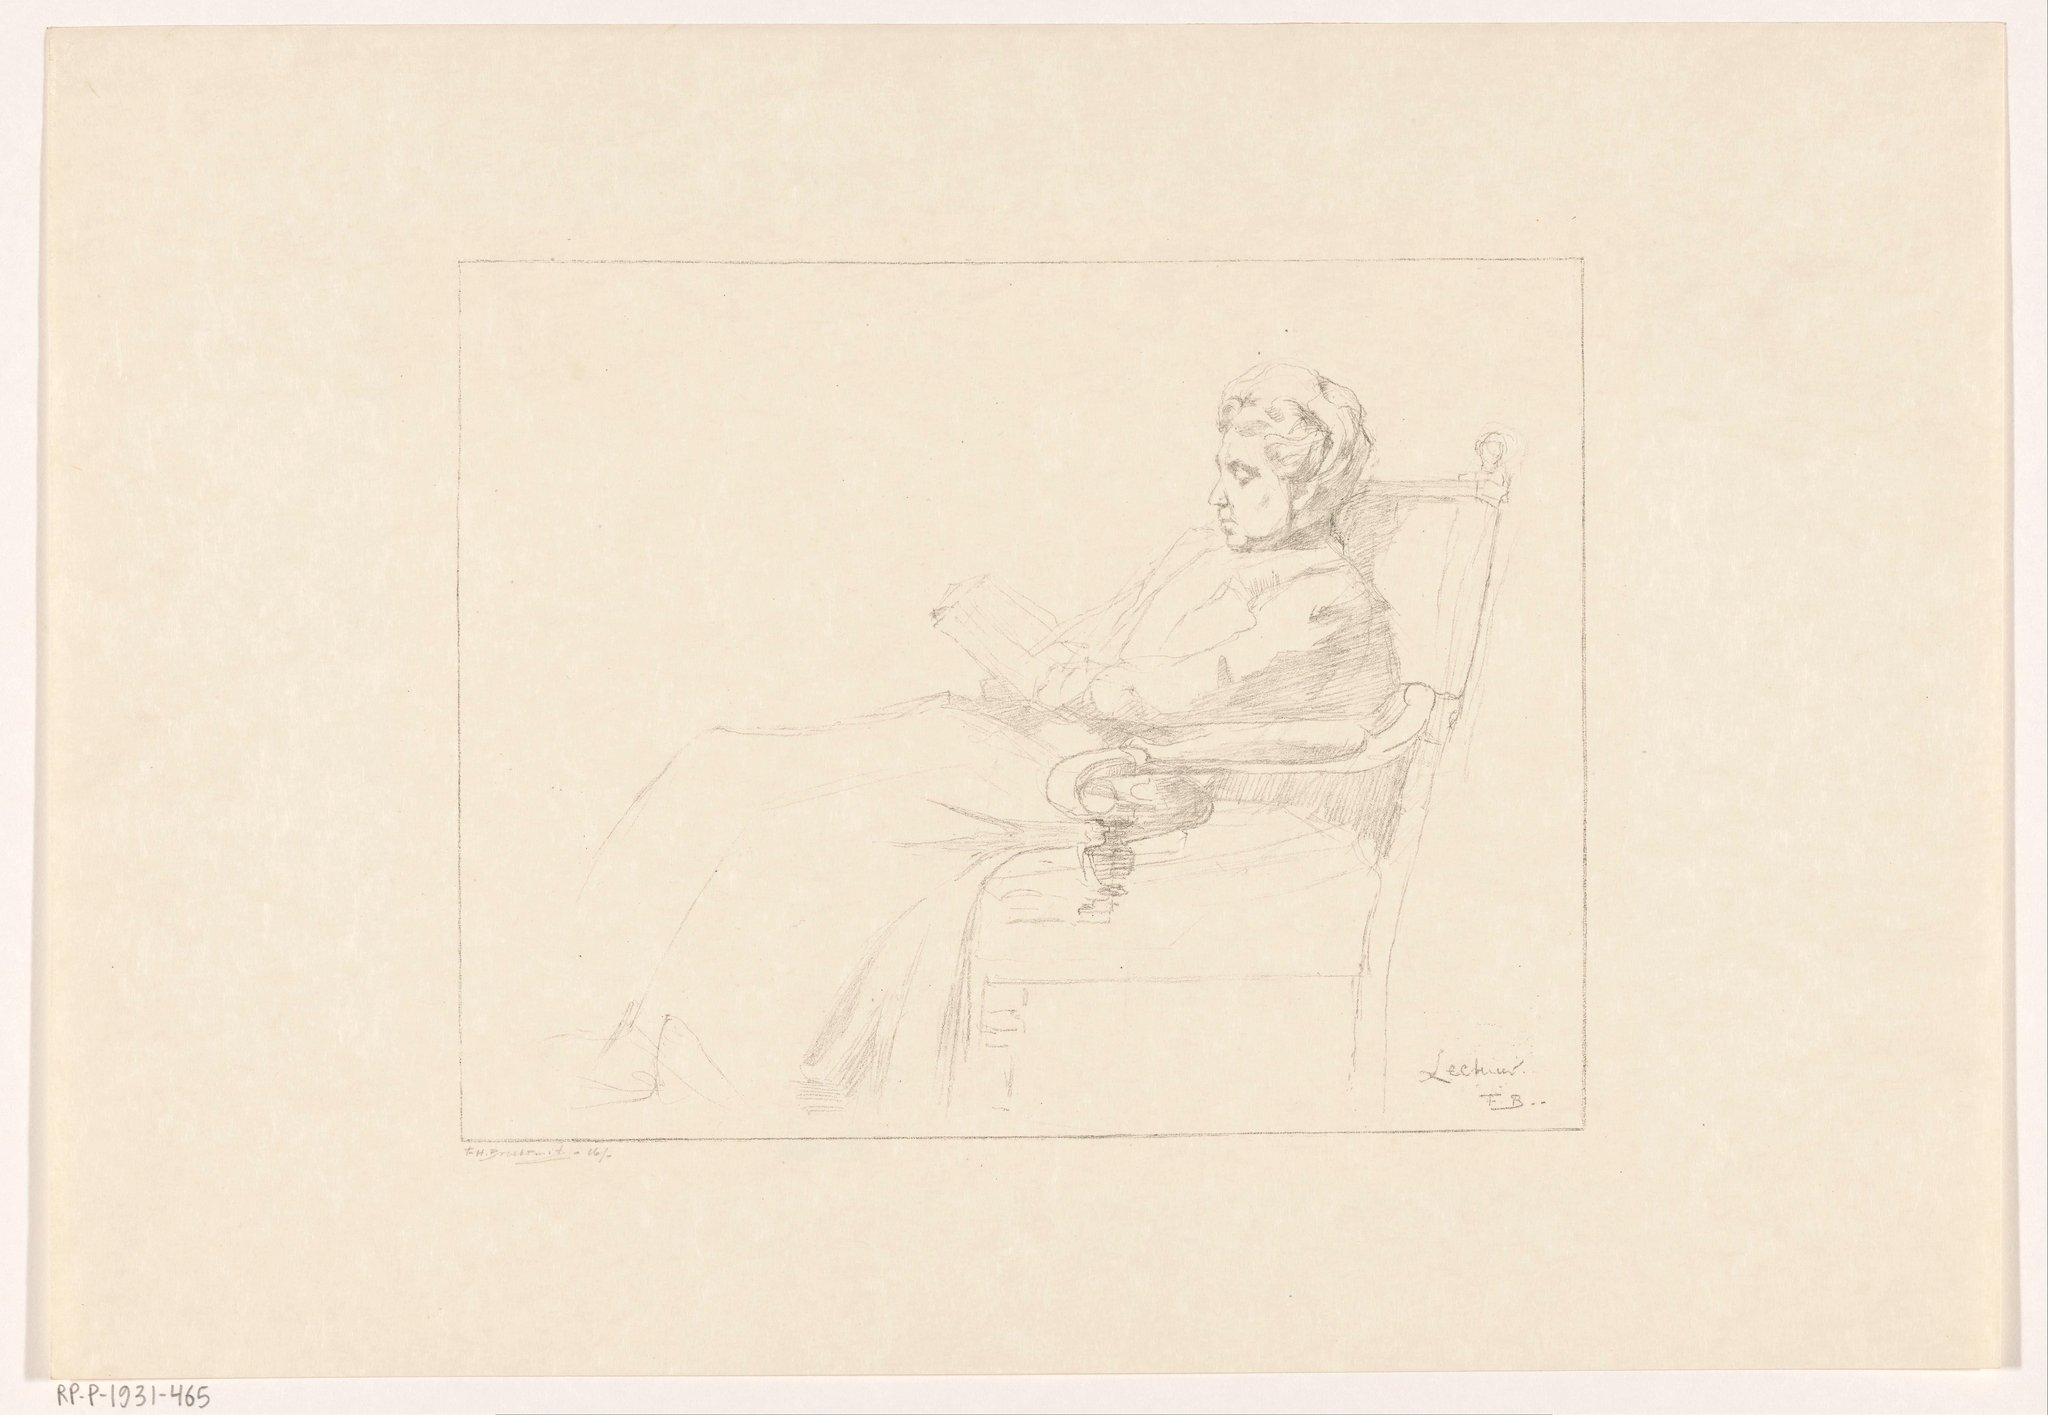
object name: print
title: Portret van een vrouw, aangeduid met V.J.-D.v.H.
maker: frederika henriëtte broeksmit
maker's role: draughtsman, print maker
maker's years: 1875-1945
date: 1905-1908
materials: paper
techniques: lithograph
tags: reading, historical persons - bb - woman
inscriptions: collector's mark: Lugt 2228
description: Titel gebaseerd op de informatie uit het inventarisboek.